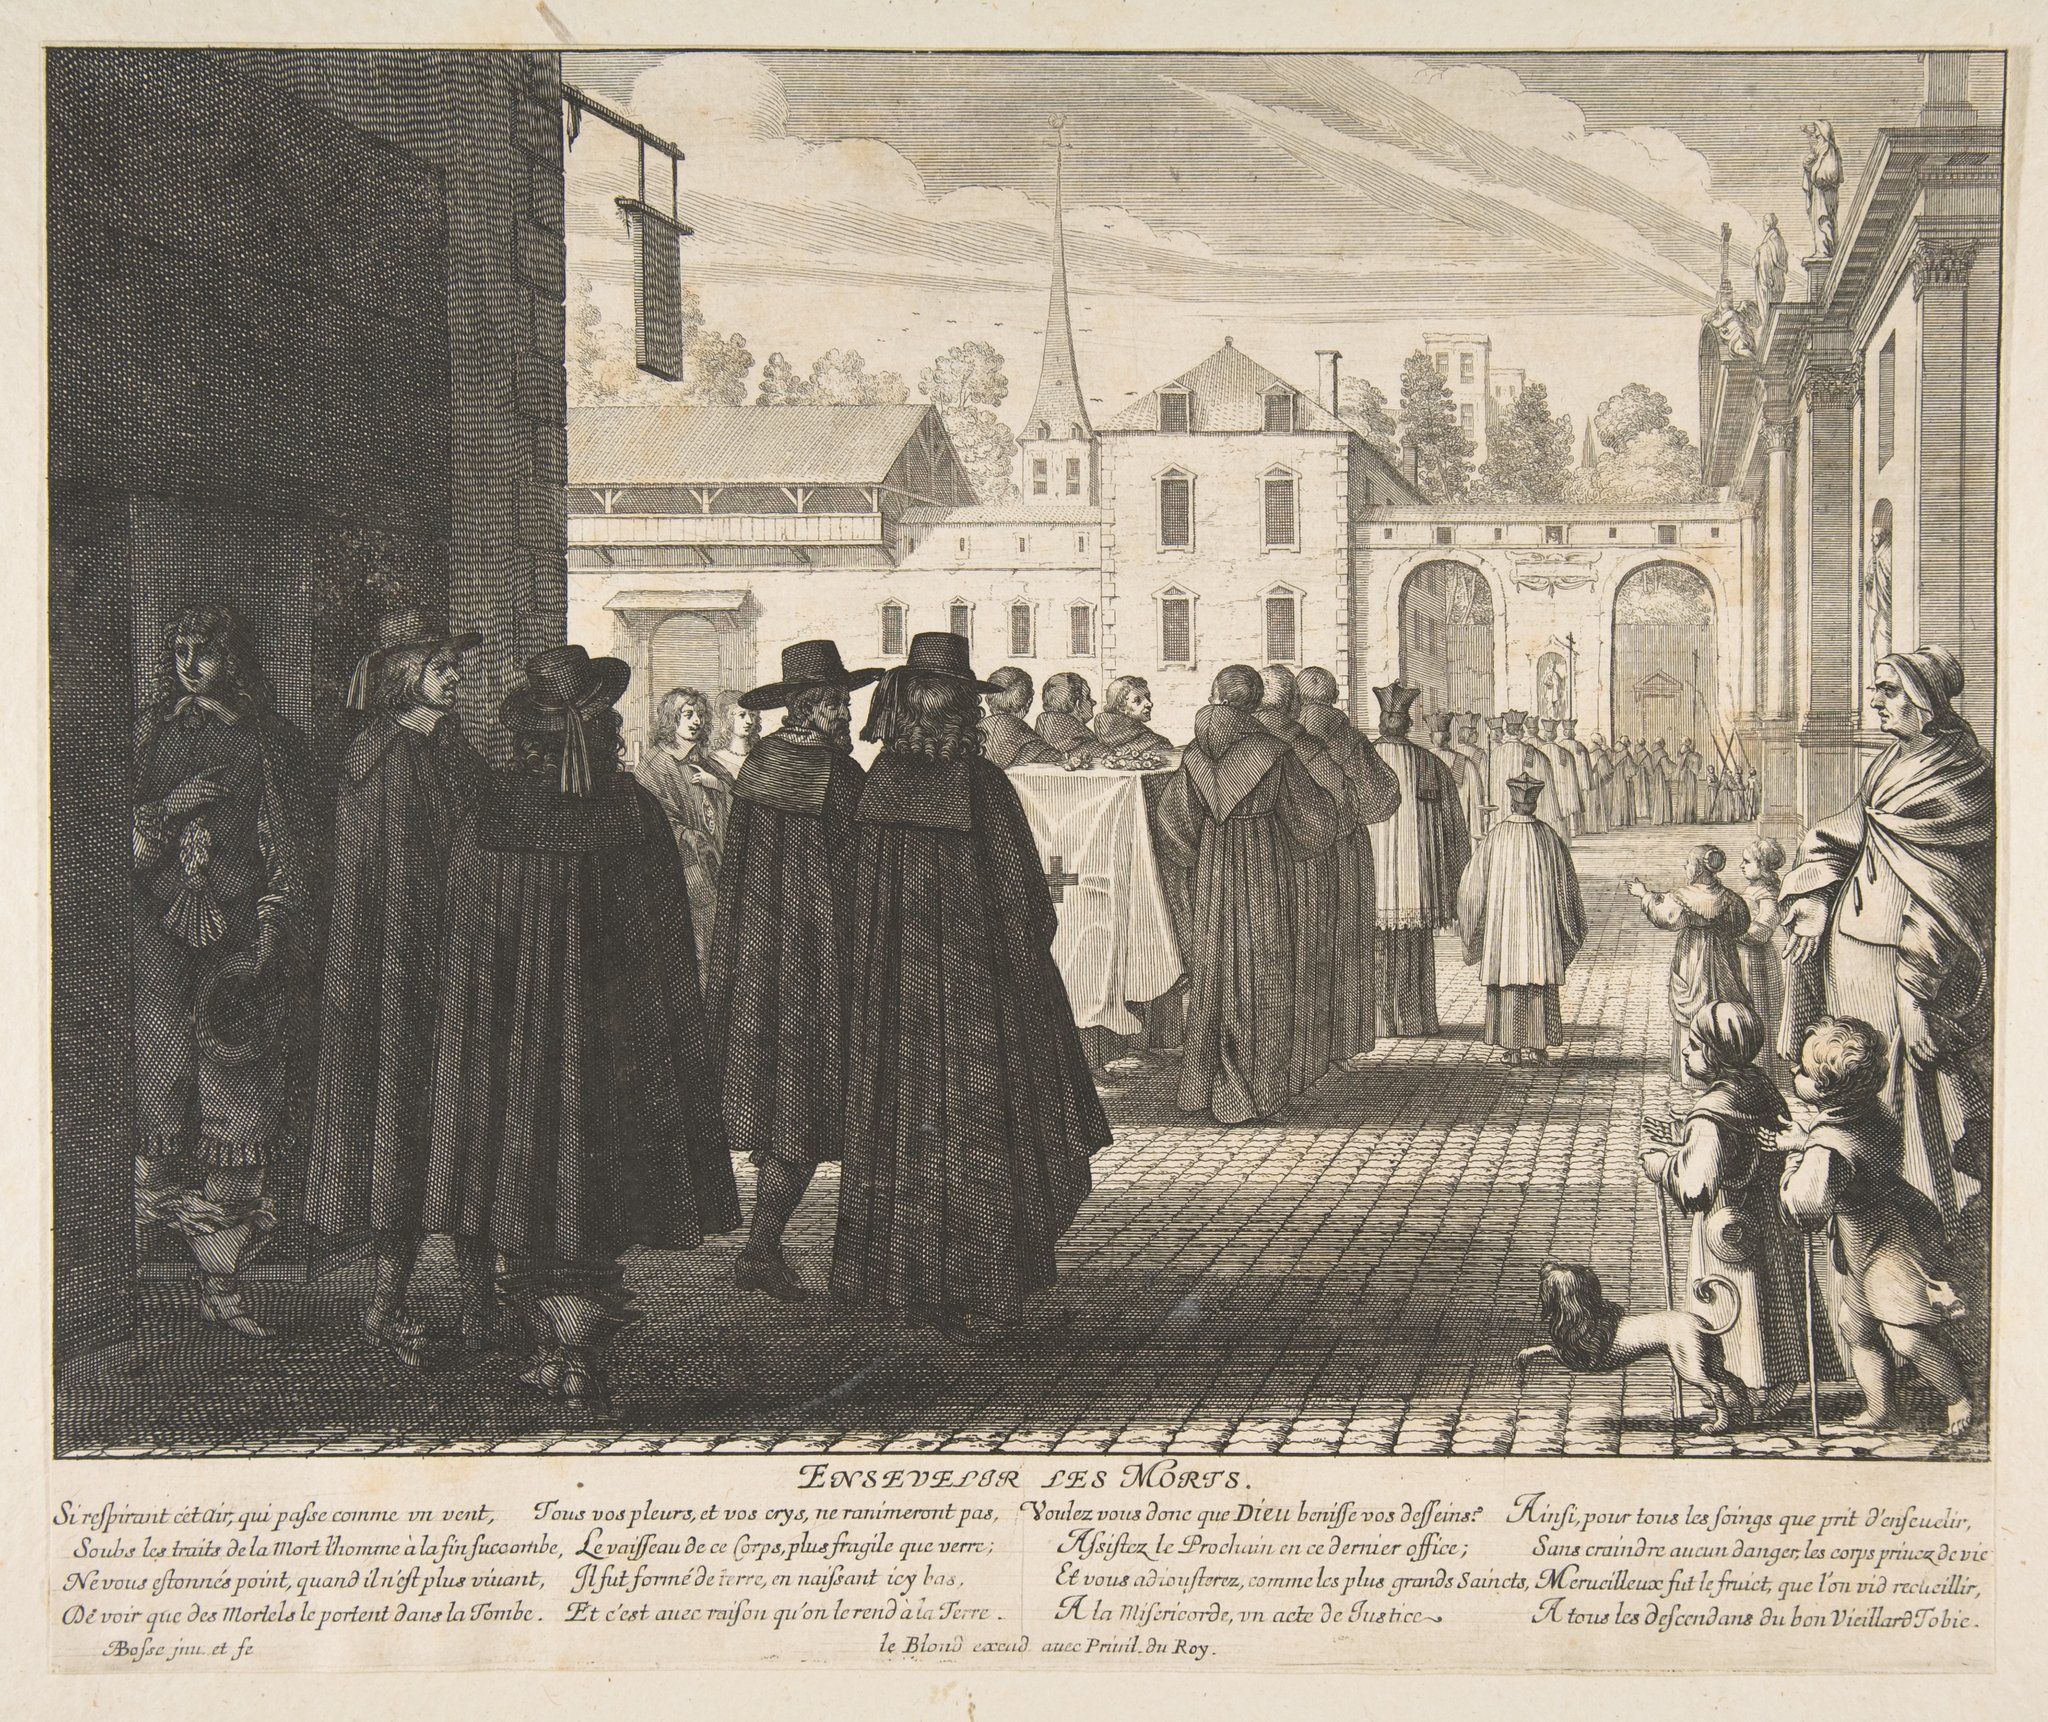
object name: print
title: Burying the Dead (Enseveliir les morts)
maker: abraham bosse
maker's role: artist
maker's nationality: french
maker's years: 1602-1676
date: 1602-1676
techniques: engraving, etching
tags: children,men,lions,funerals